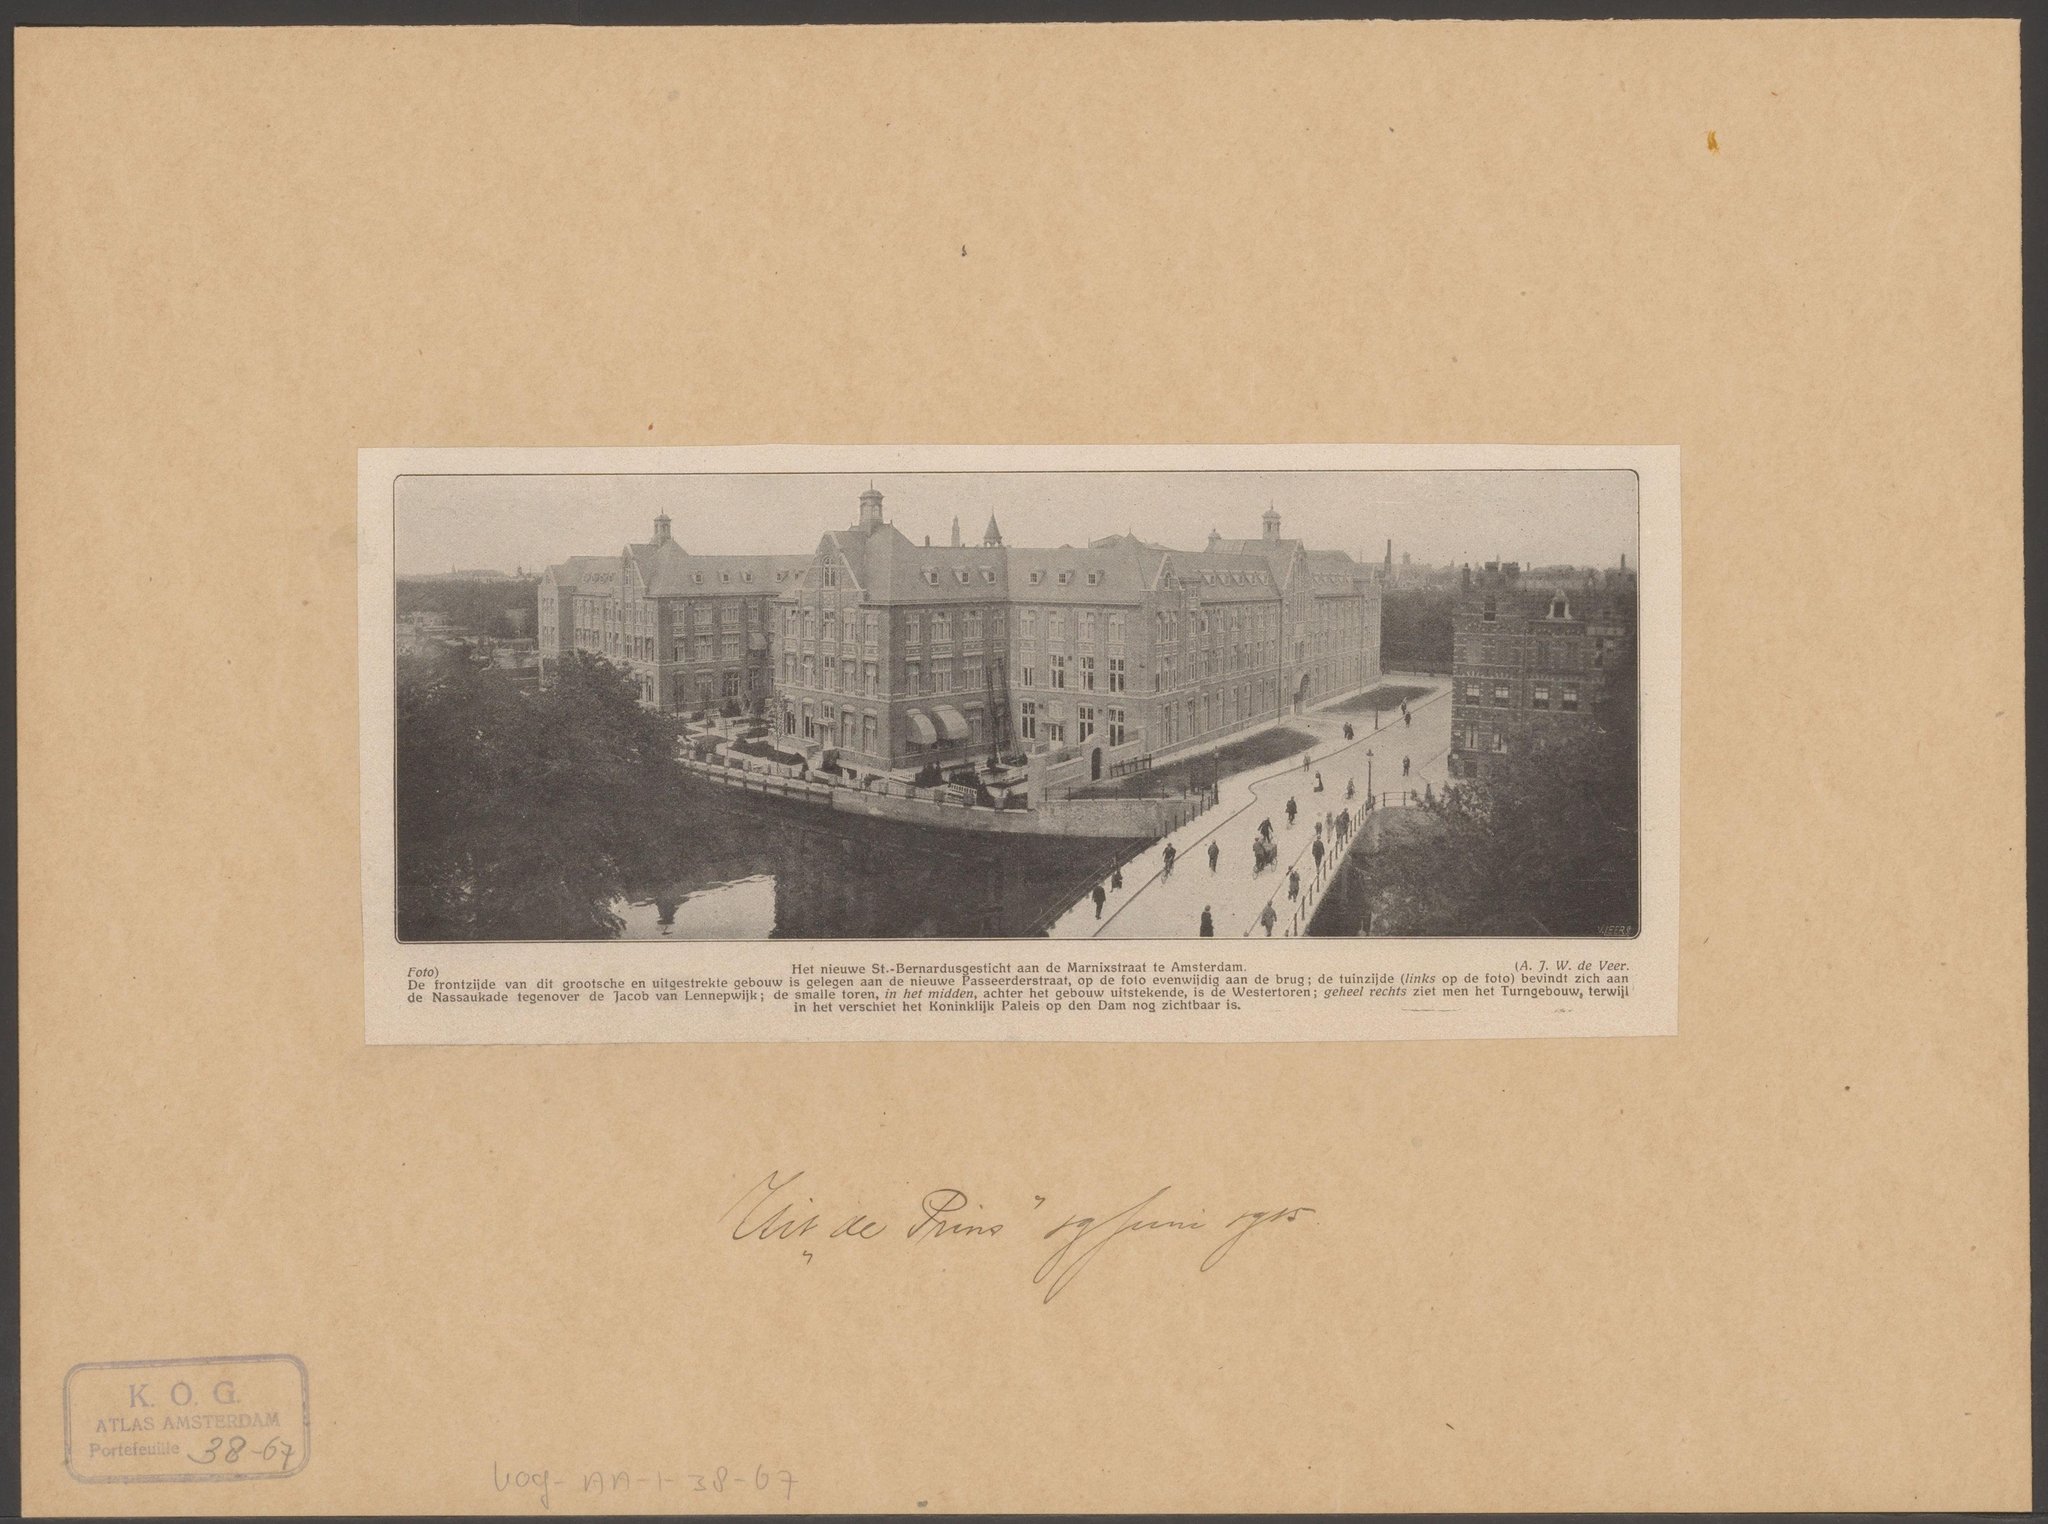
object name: photomechanical print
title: Gezicht op het Sint-Bernardusgesticht te Amsterdam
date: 1915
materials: paper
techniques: letterpress printing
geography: amsterdam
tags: bridge in city across river, canal, etc. (+ city(-scape) with figures, staffage), old-people's home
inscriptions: collector's mark: Lugt 1641b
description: Onderwerpsrubriek binnen de Atlas Amsterdam: Armwezen en liefdadige instellingen: II. Kerkelijke inrichtingen: Inrichtingen der Roomsch-Katholieken.